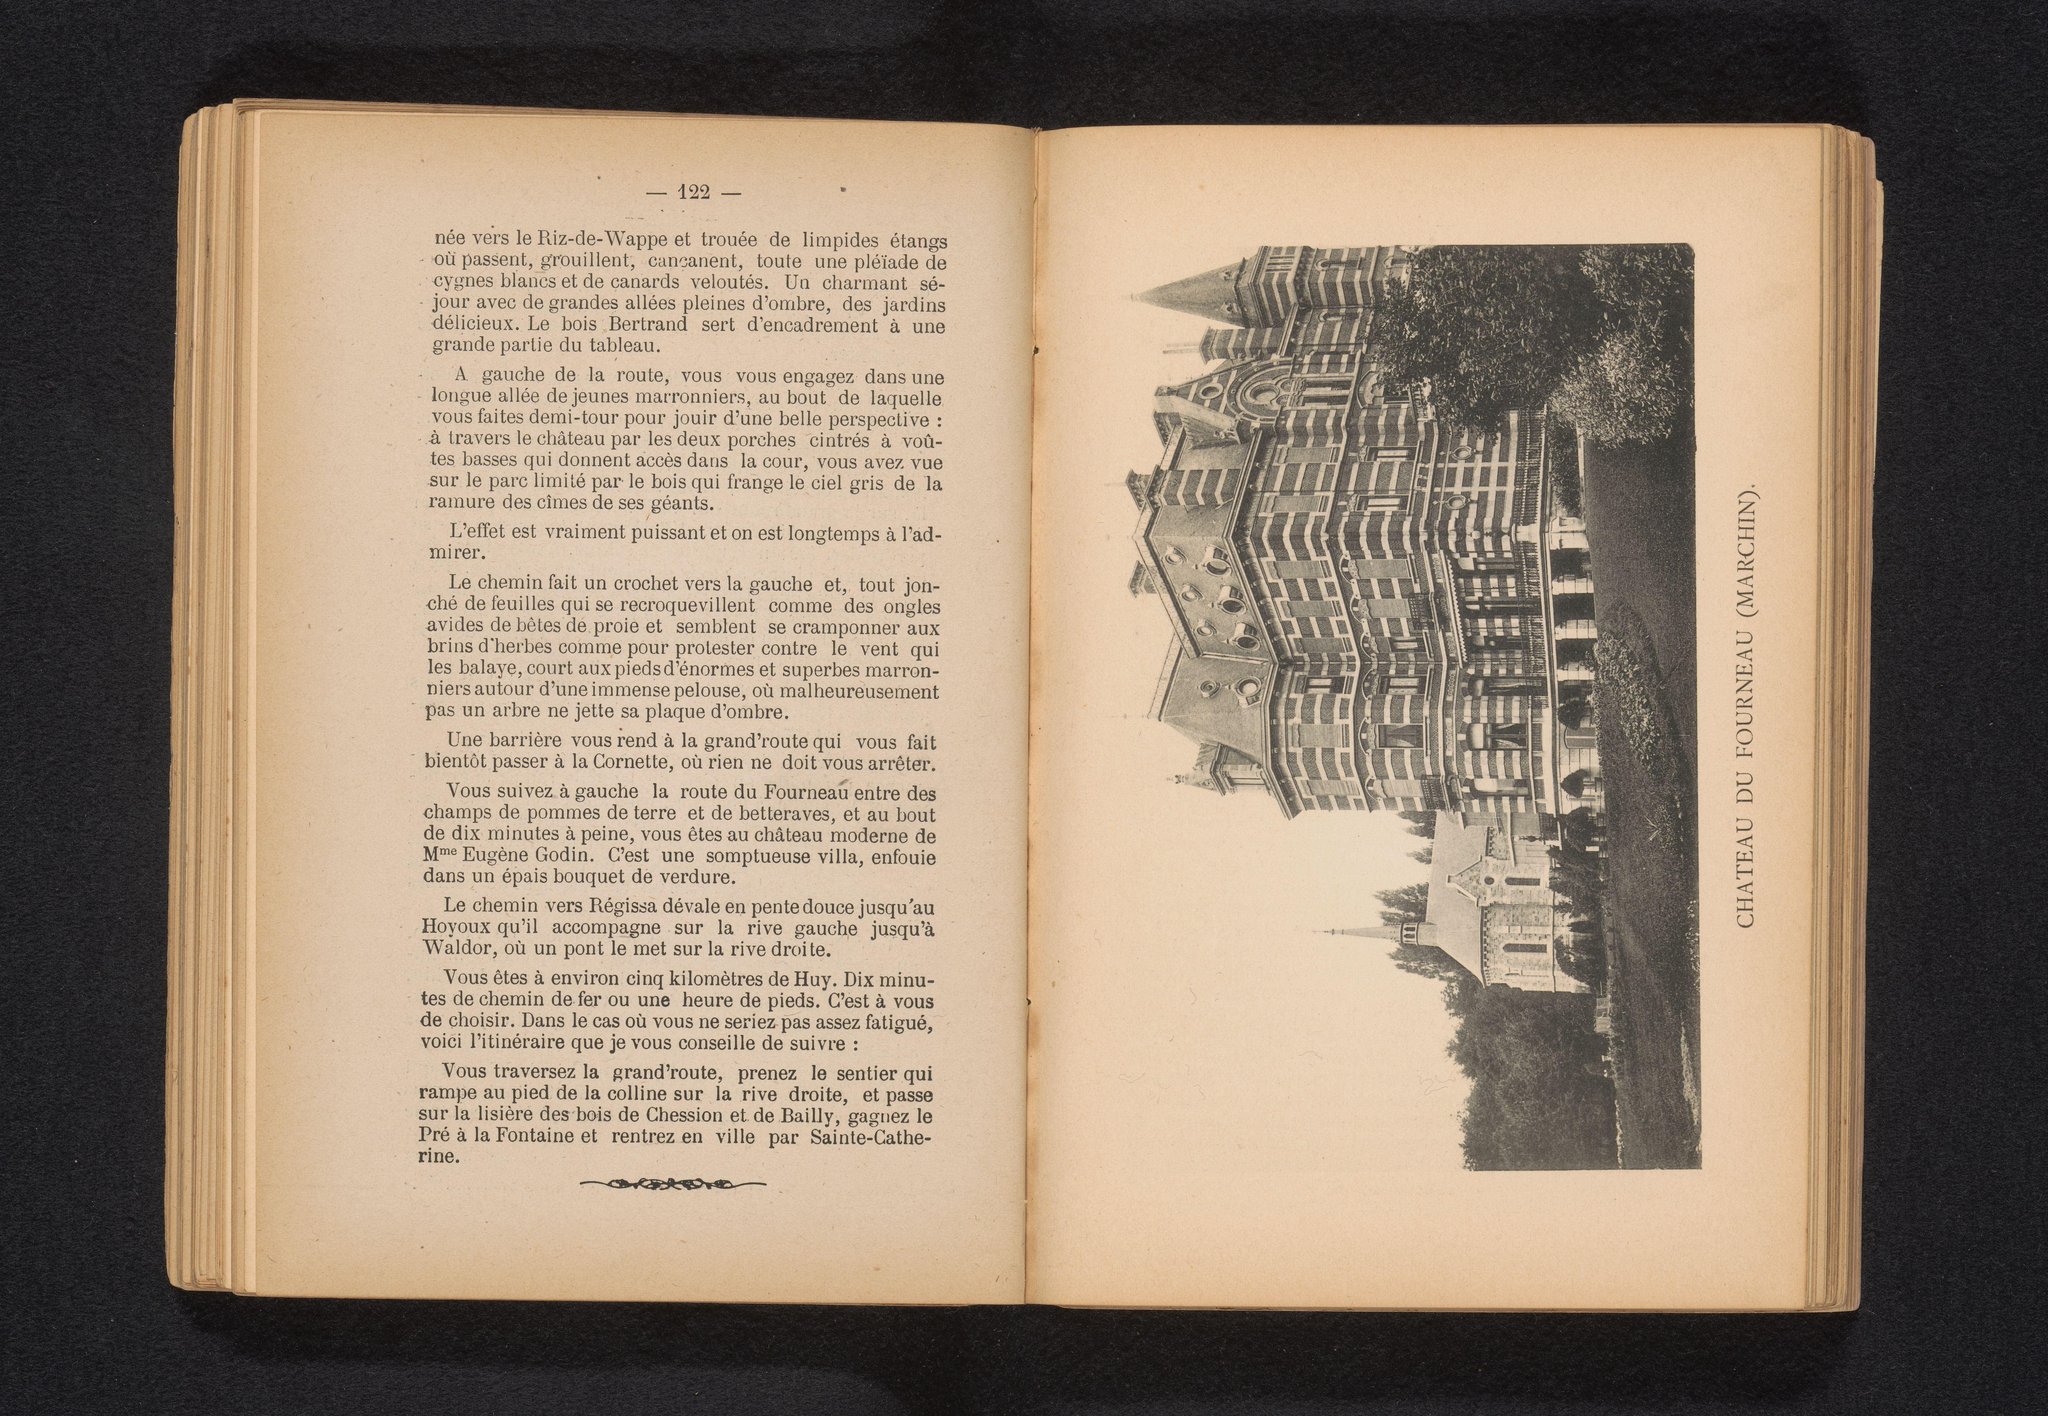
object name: page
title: Chateau du Forneau (Marchin)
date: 1885-1890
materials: paper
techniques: photograph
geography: marchin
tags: castle